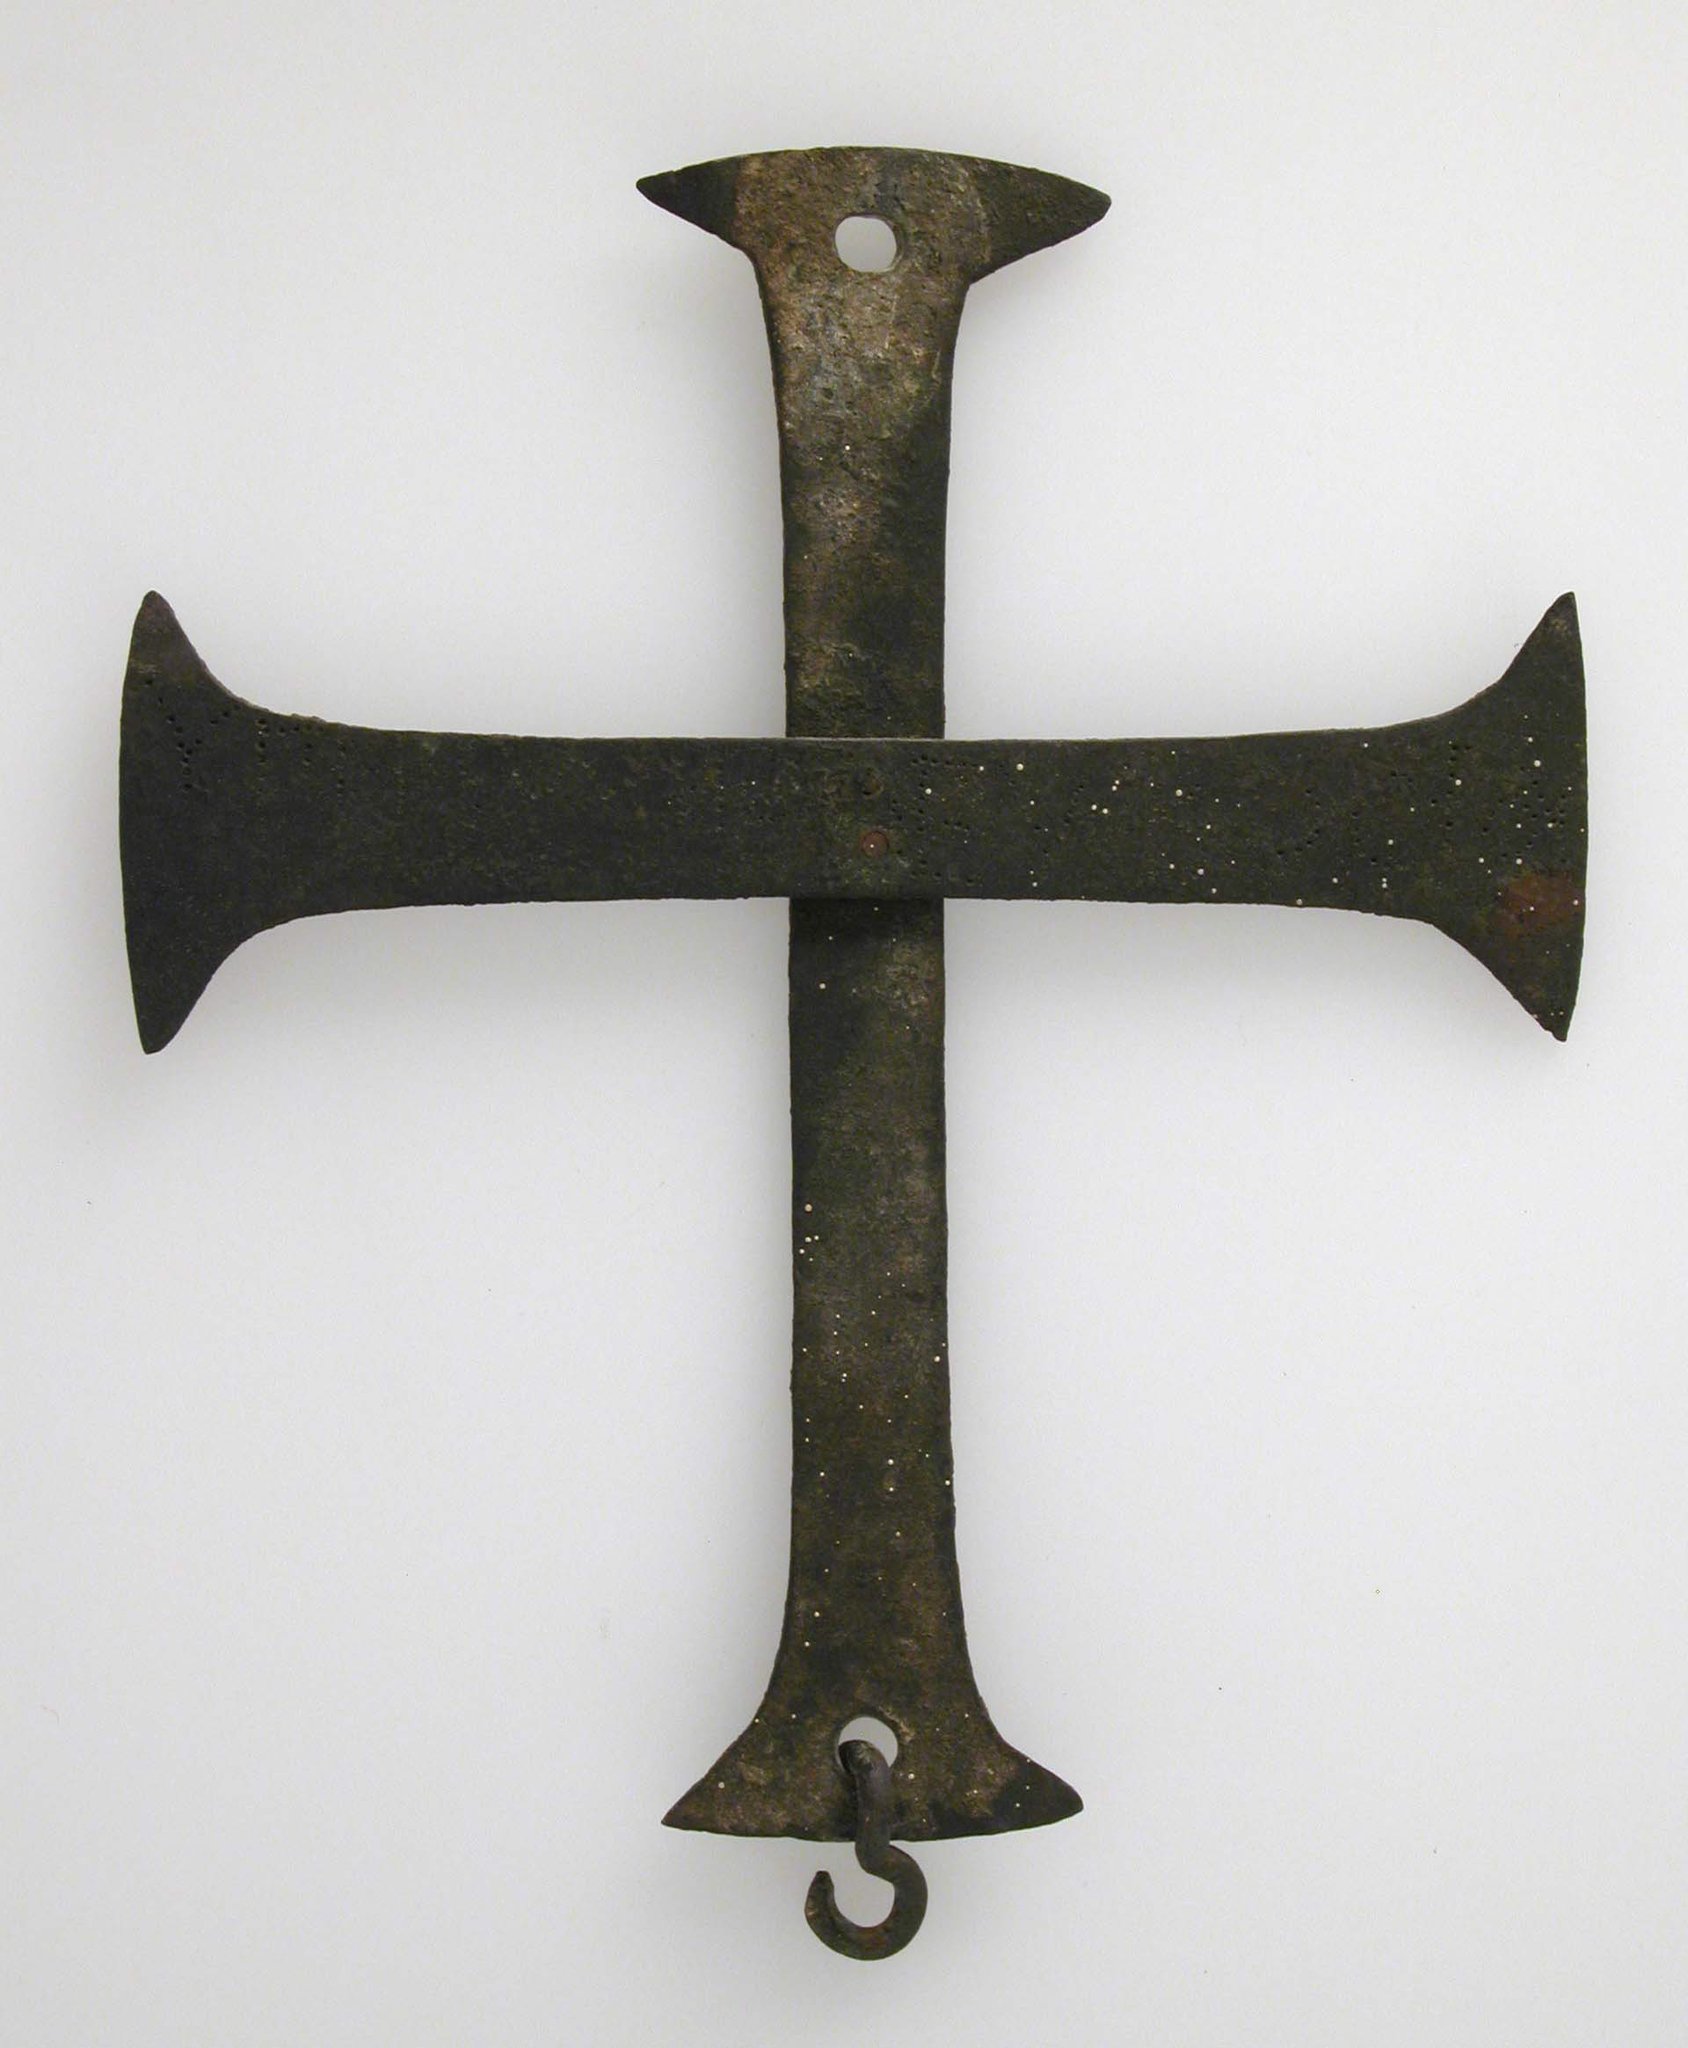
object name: cross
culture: byzantine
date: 501-600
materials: copper alloy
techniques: casting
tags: cross